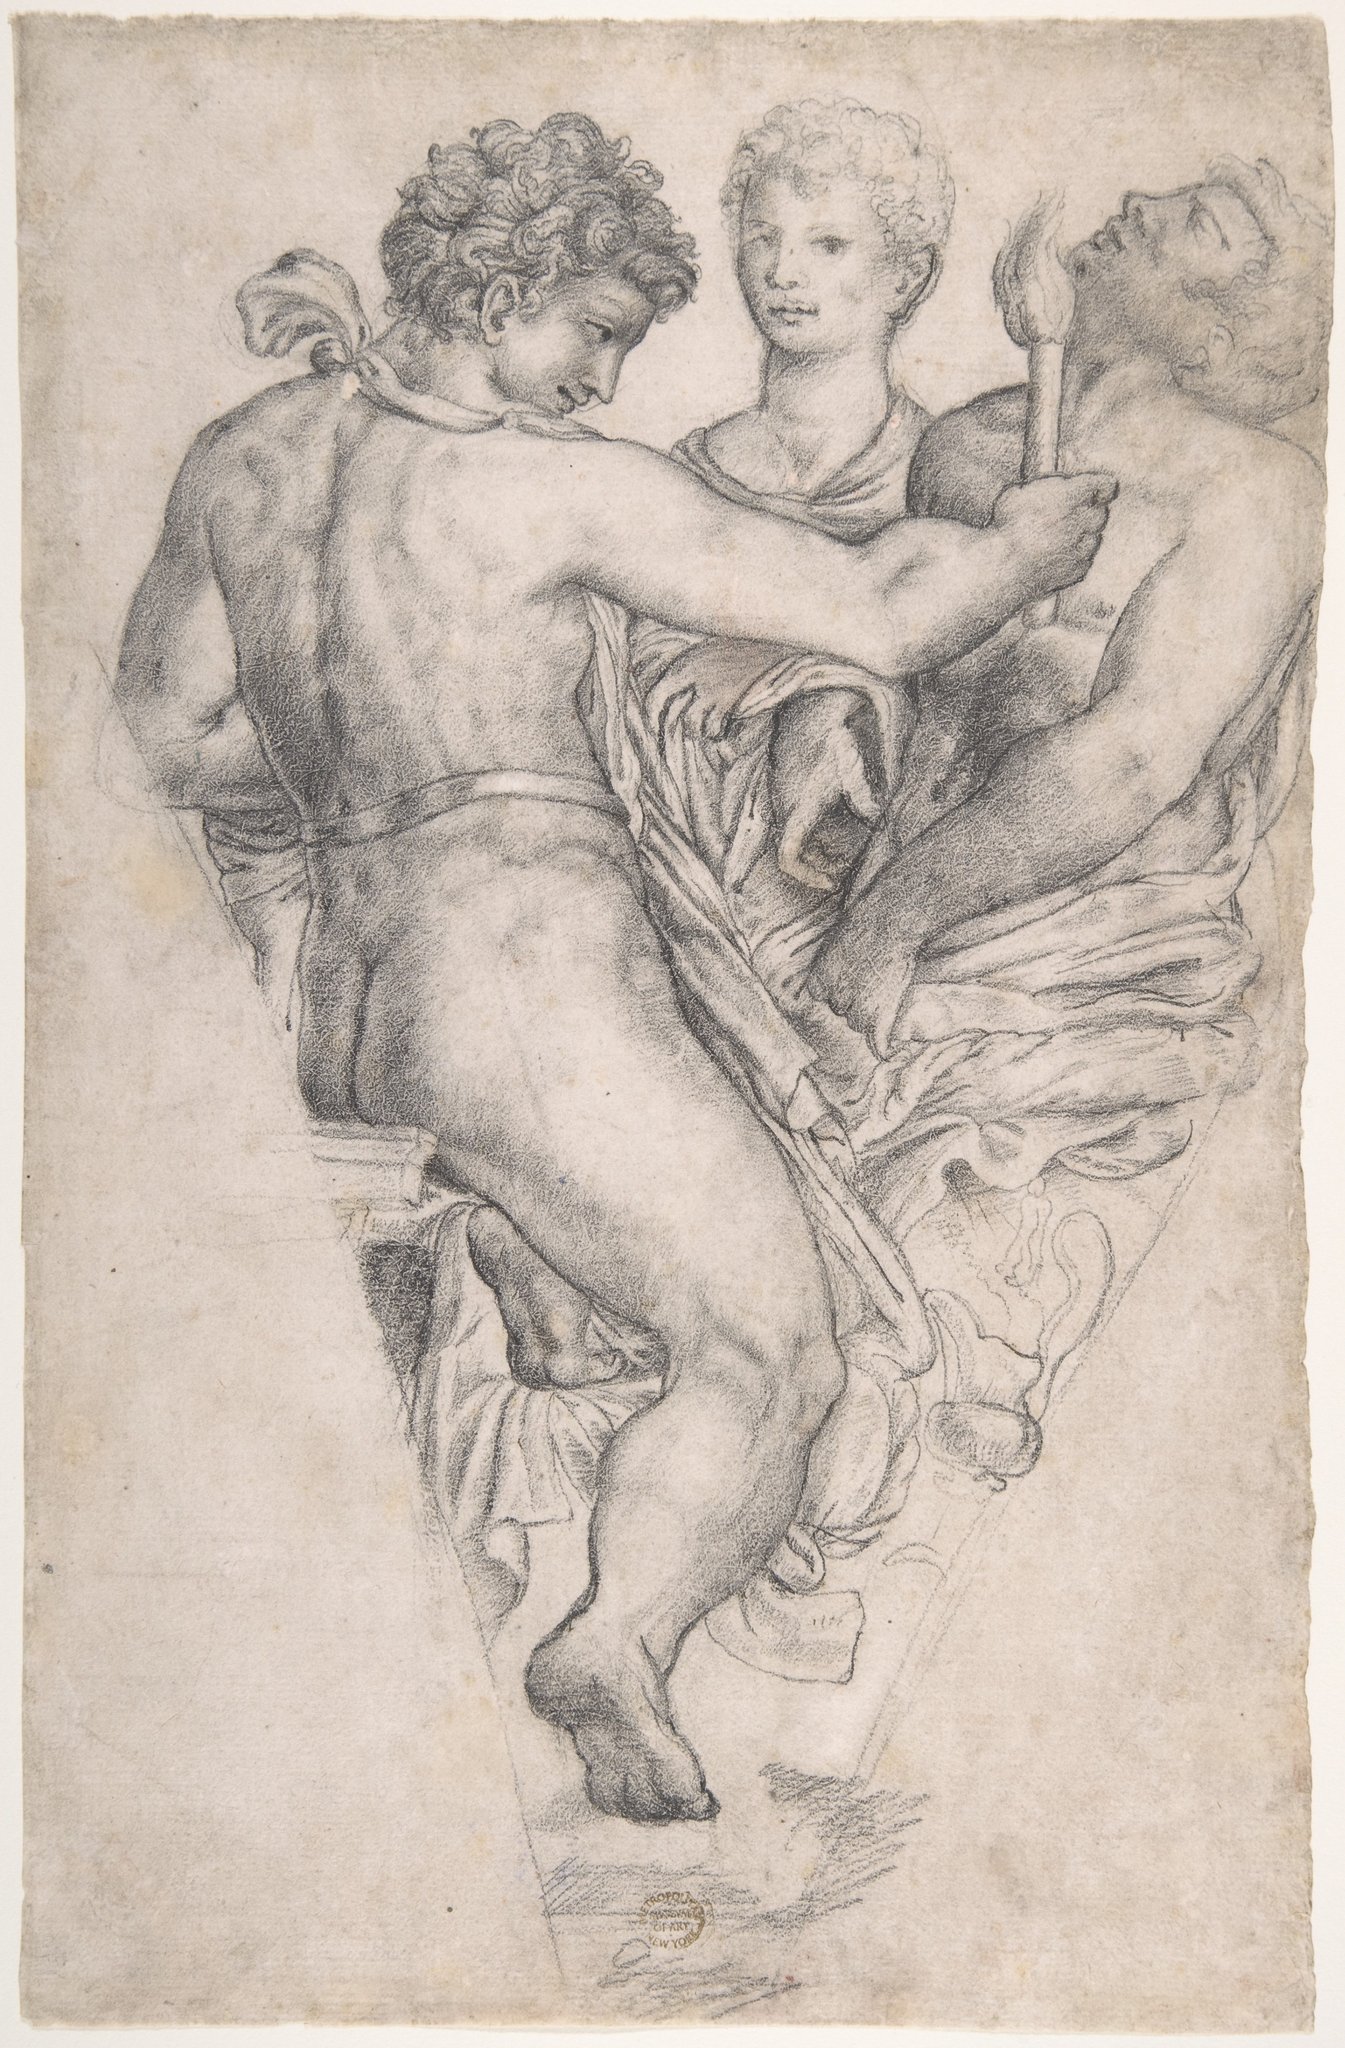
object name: drawing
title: Composition for a Spandrel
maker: anonymous, italian, 16th century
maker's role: artist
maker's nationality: italian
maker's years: 1550-1600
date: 1501-1600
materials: chalk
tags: men,women